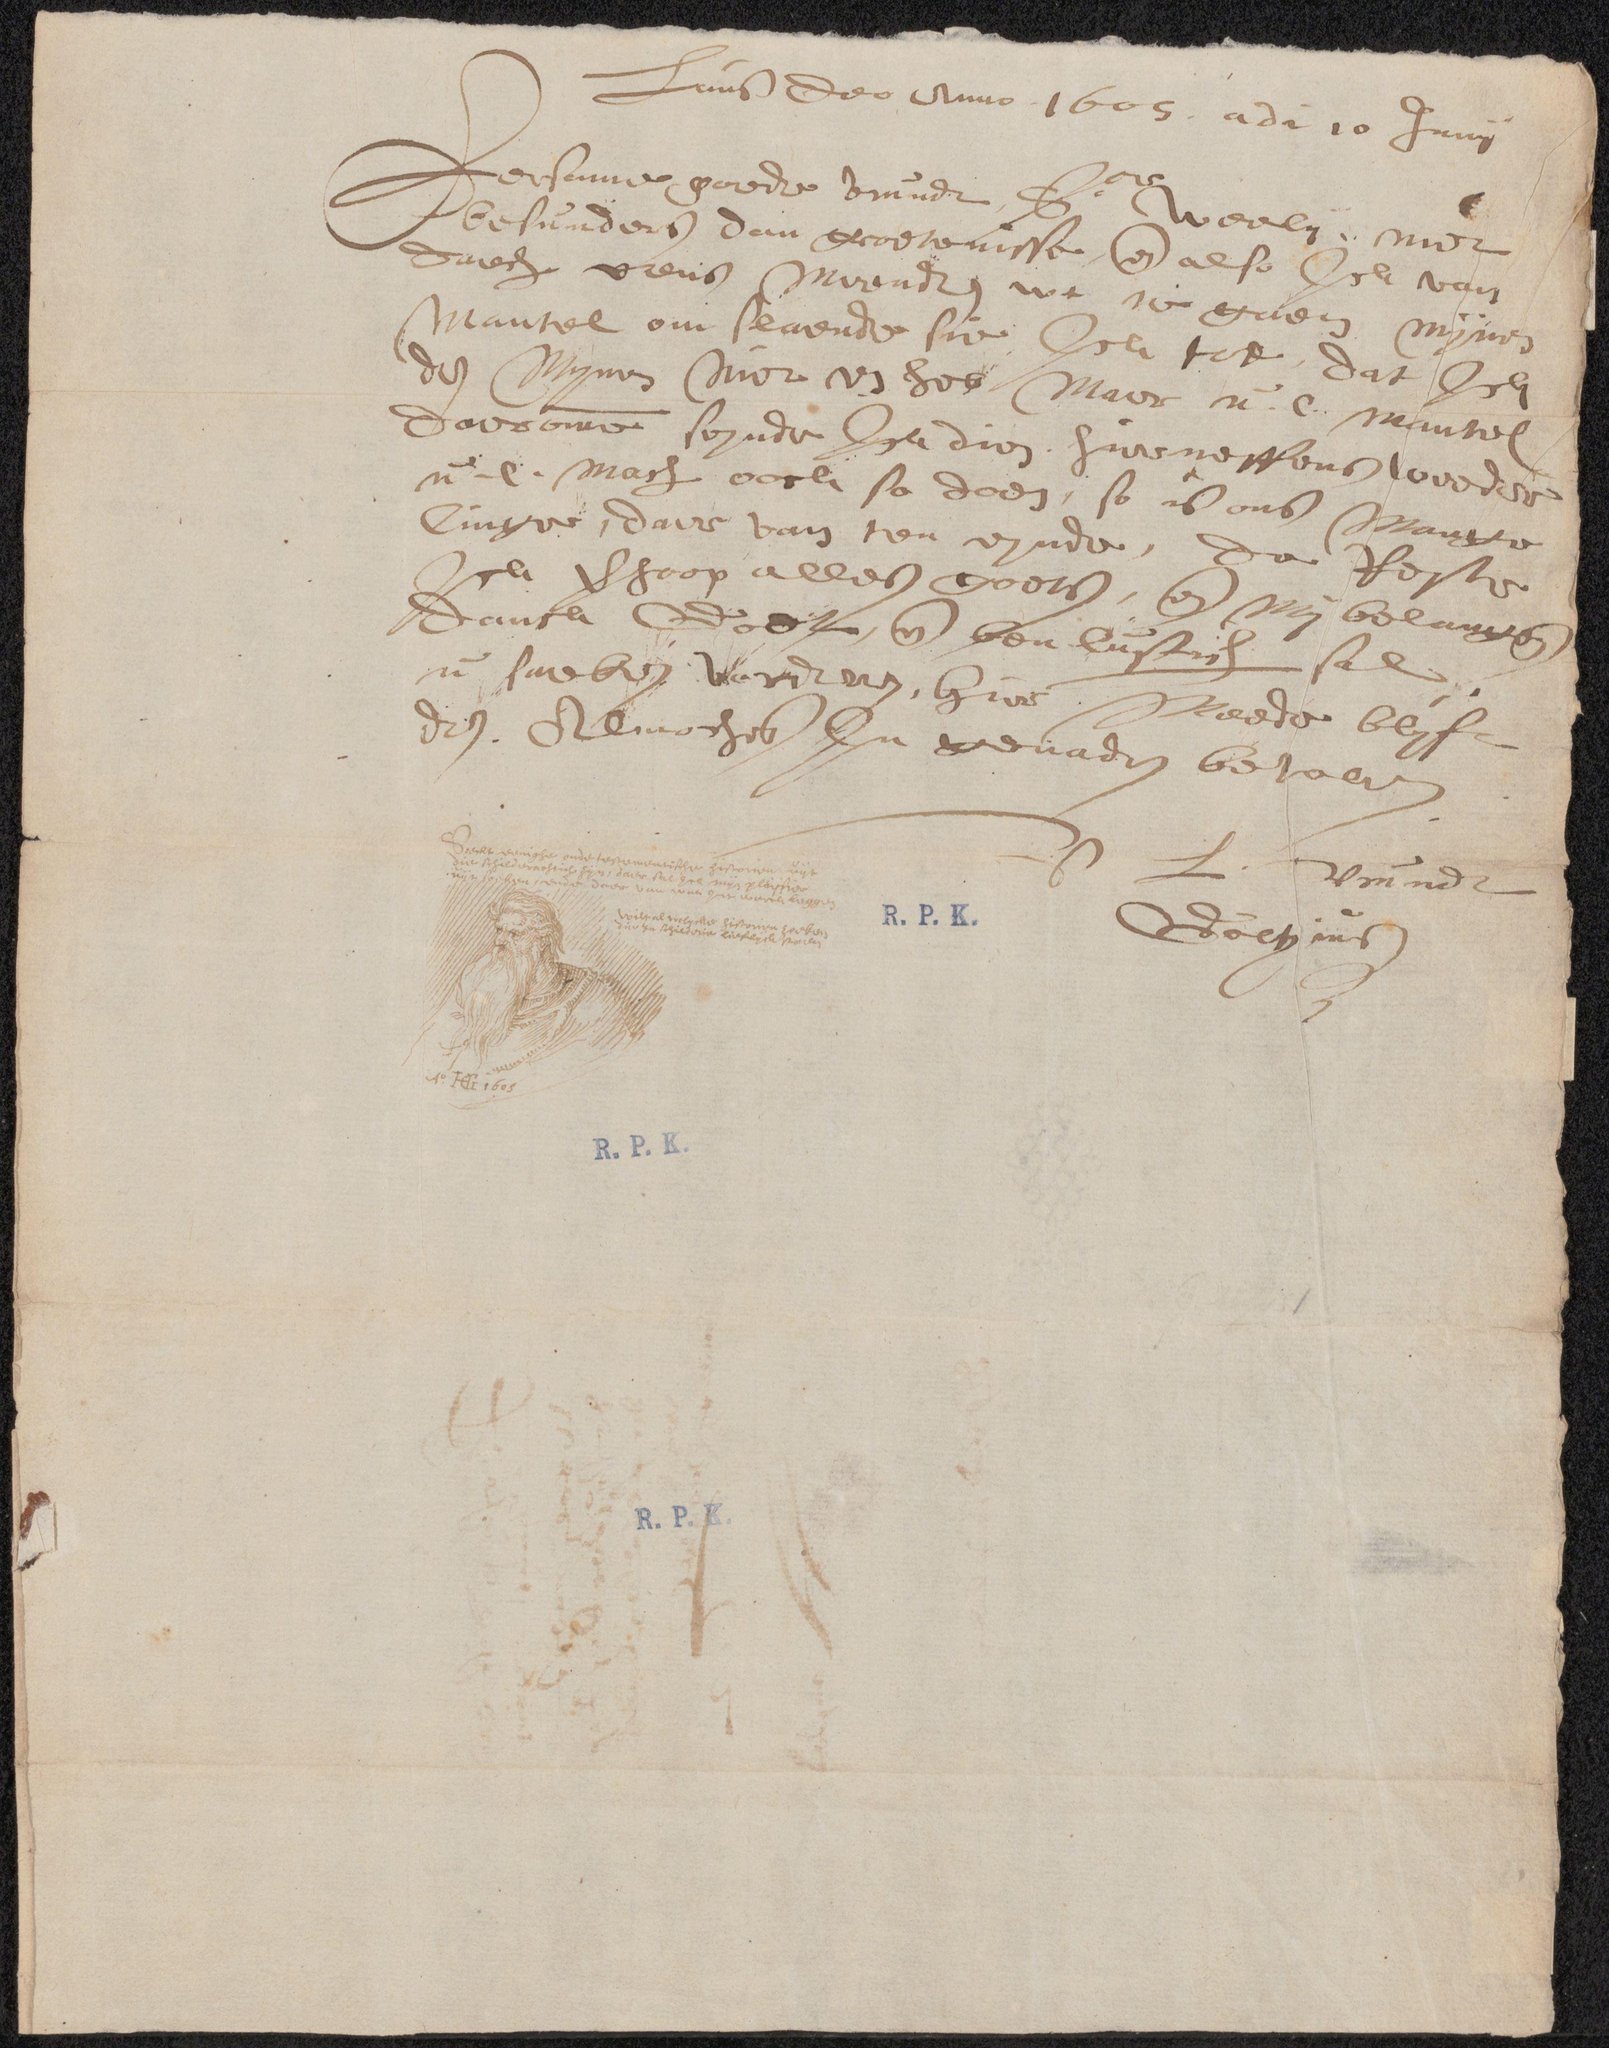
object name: drawing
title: Brief aan Jan van Wely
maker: hendrick goltzius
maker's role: draughtsman, painter, print maker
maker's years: 1558-1617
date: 1605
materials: ink, paper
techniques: pen, writing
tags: old man (+ three-quarter view)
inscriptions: seal, collector's mark: Lugt 2233, collector's mark: Lugt 2228a, watermark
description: De brief begeleide een mantel welke Goltzius aan Van Weely retourneerde.